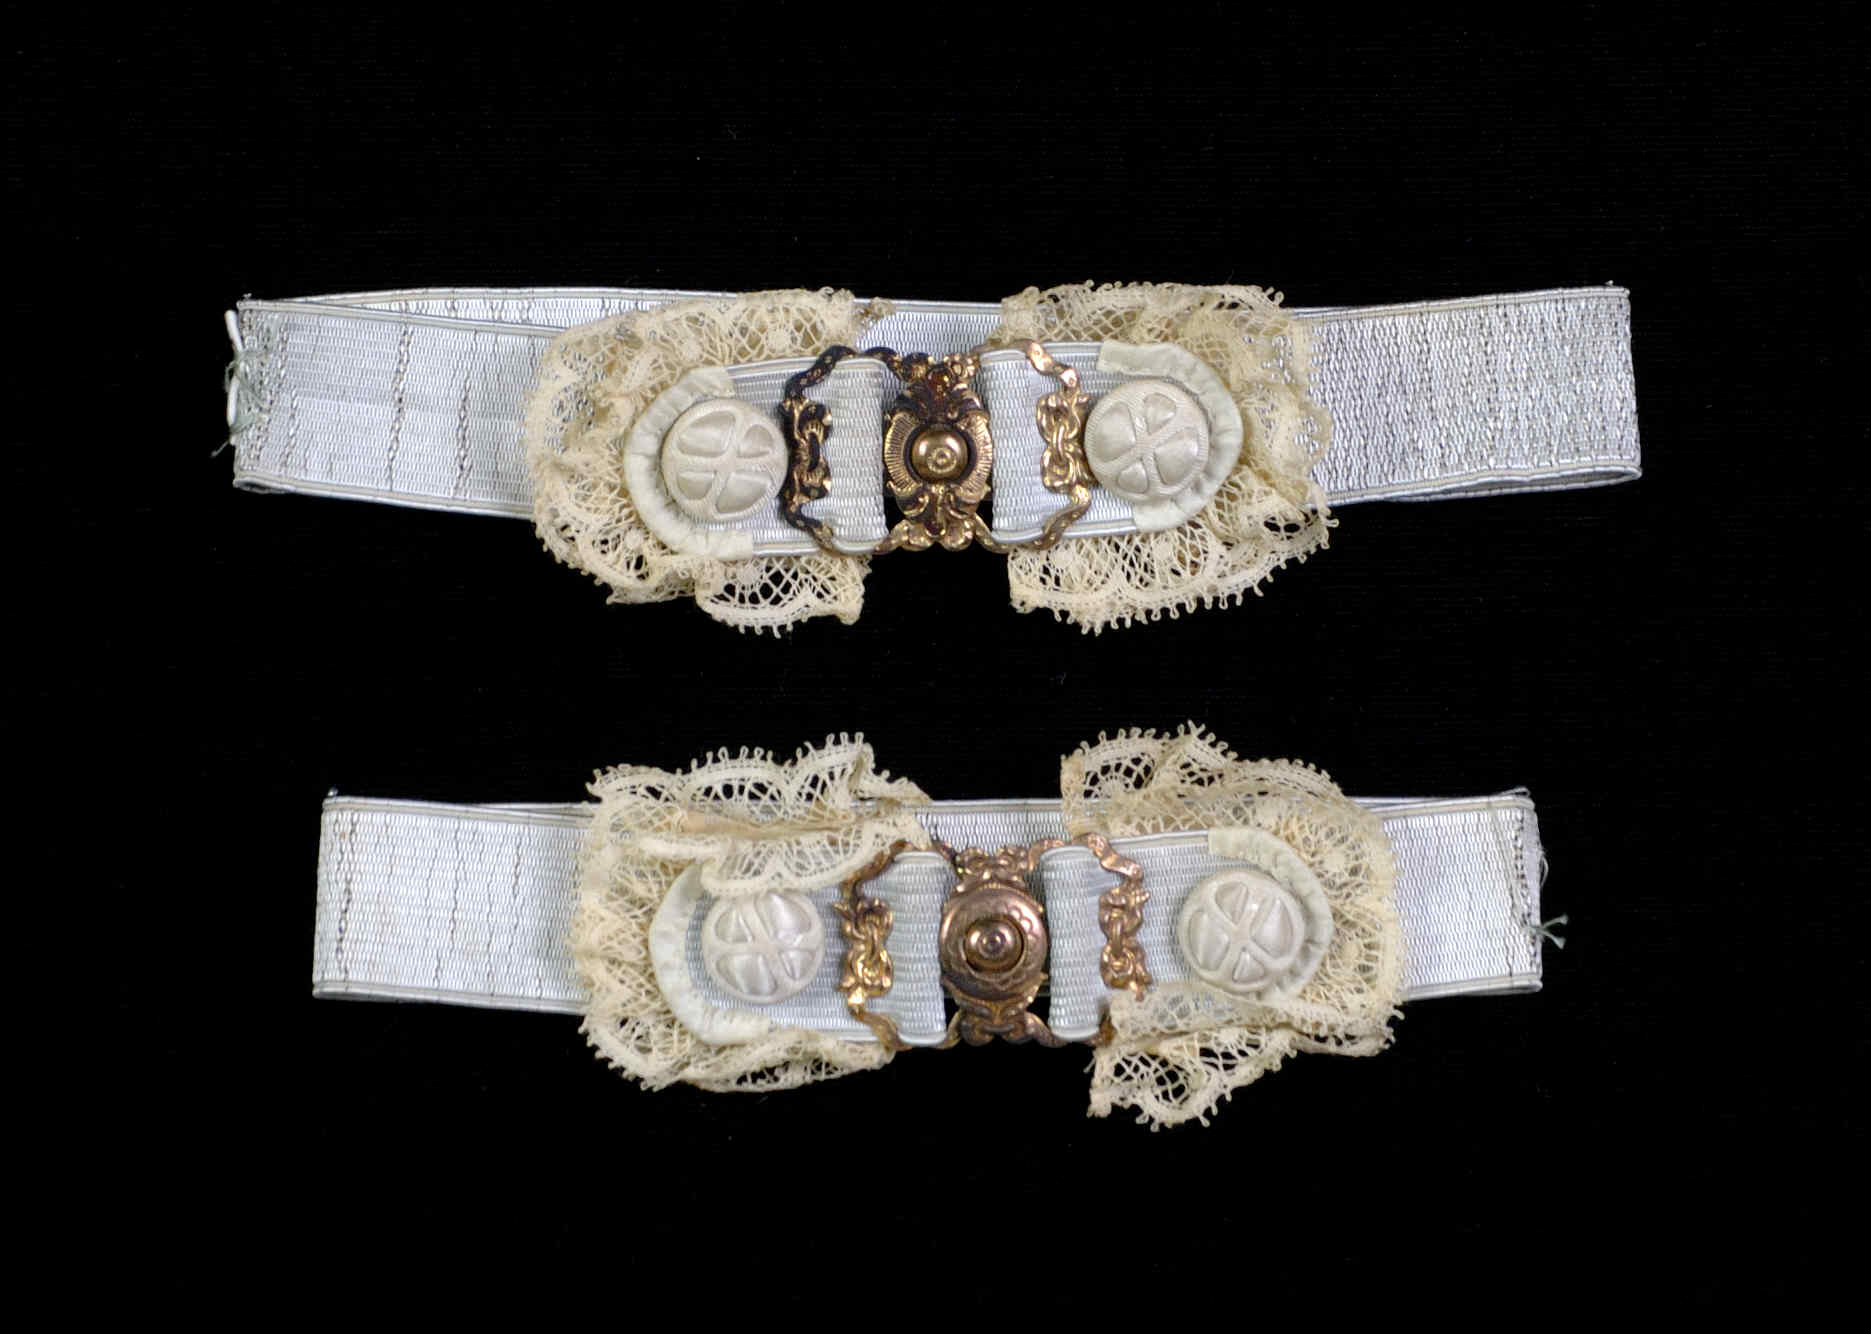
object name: garter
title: Garters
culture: american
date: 1890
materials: linen, metal